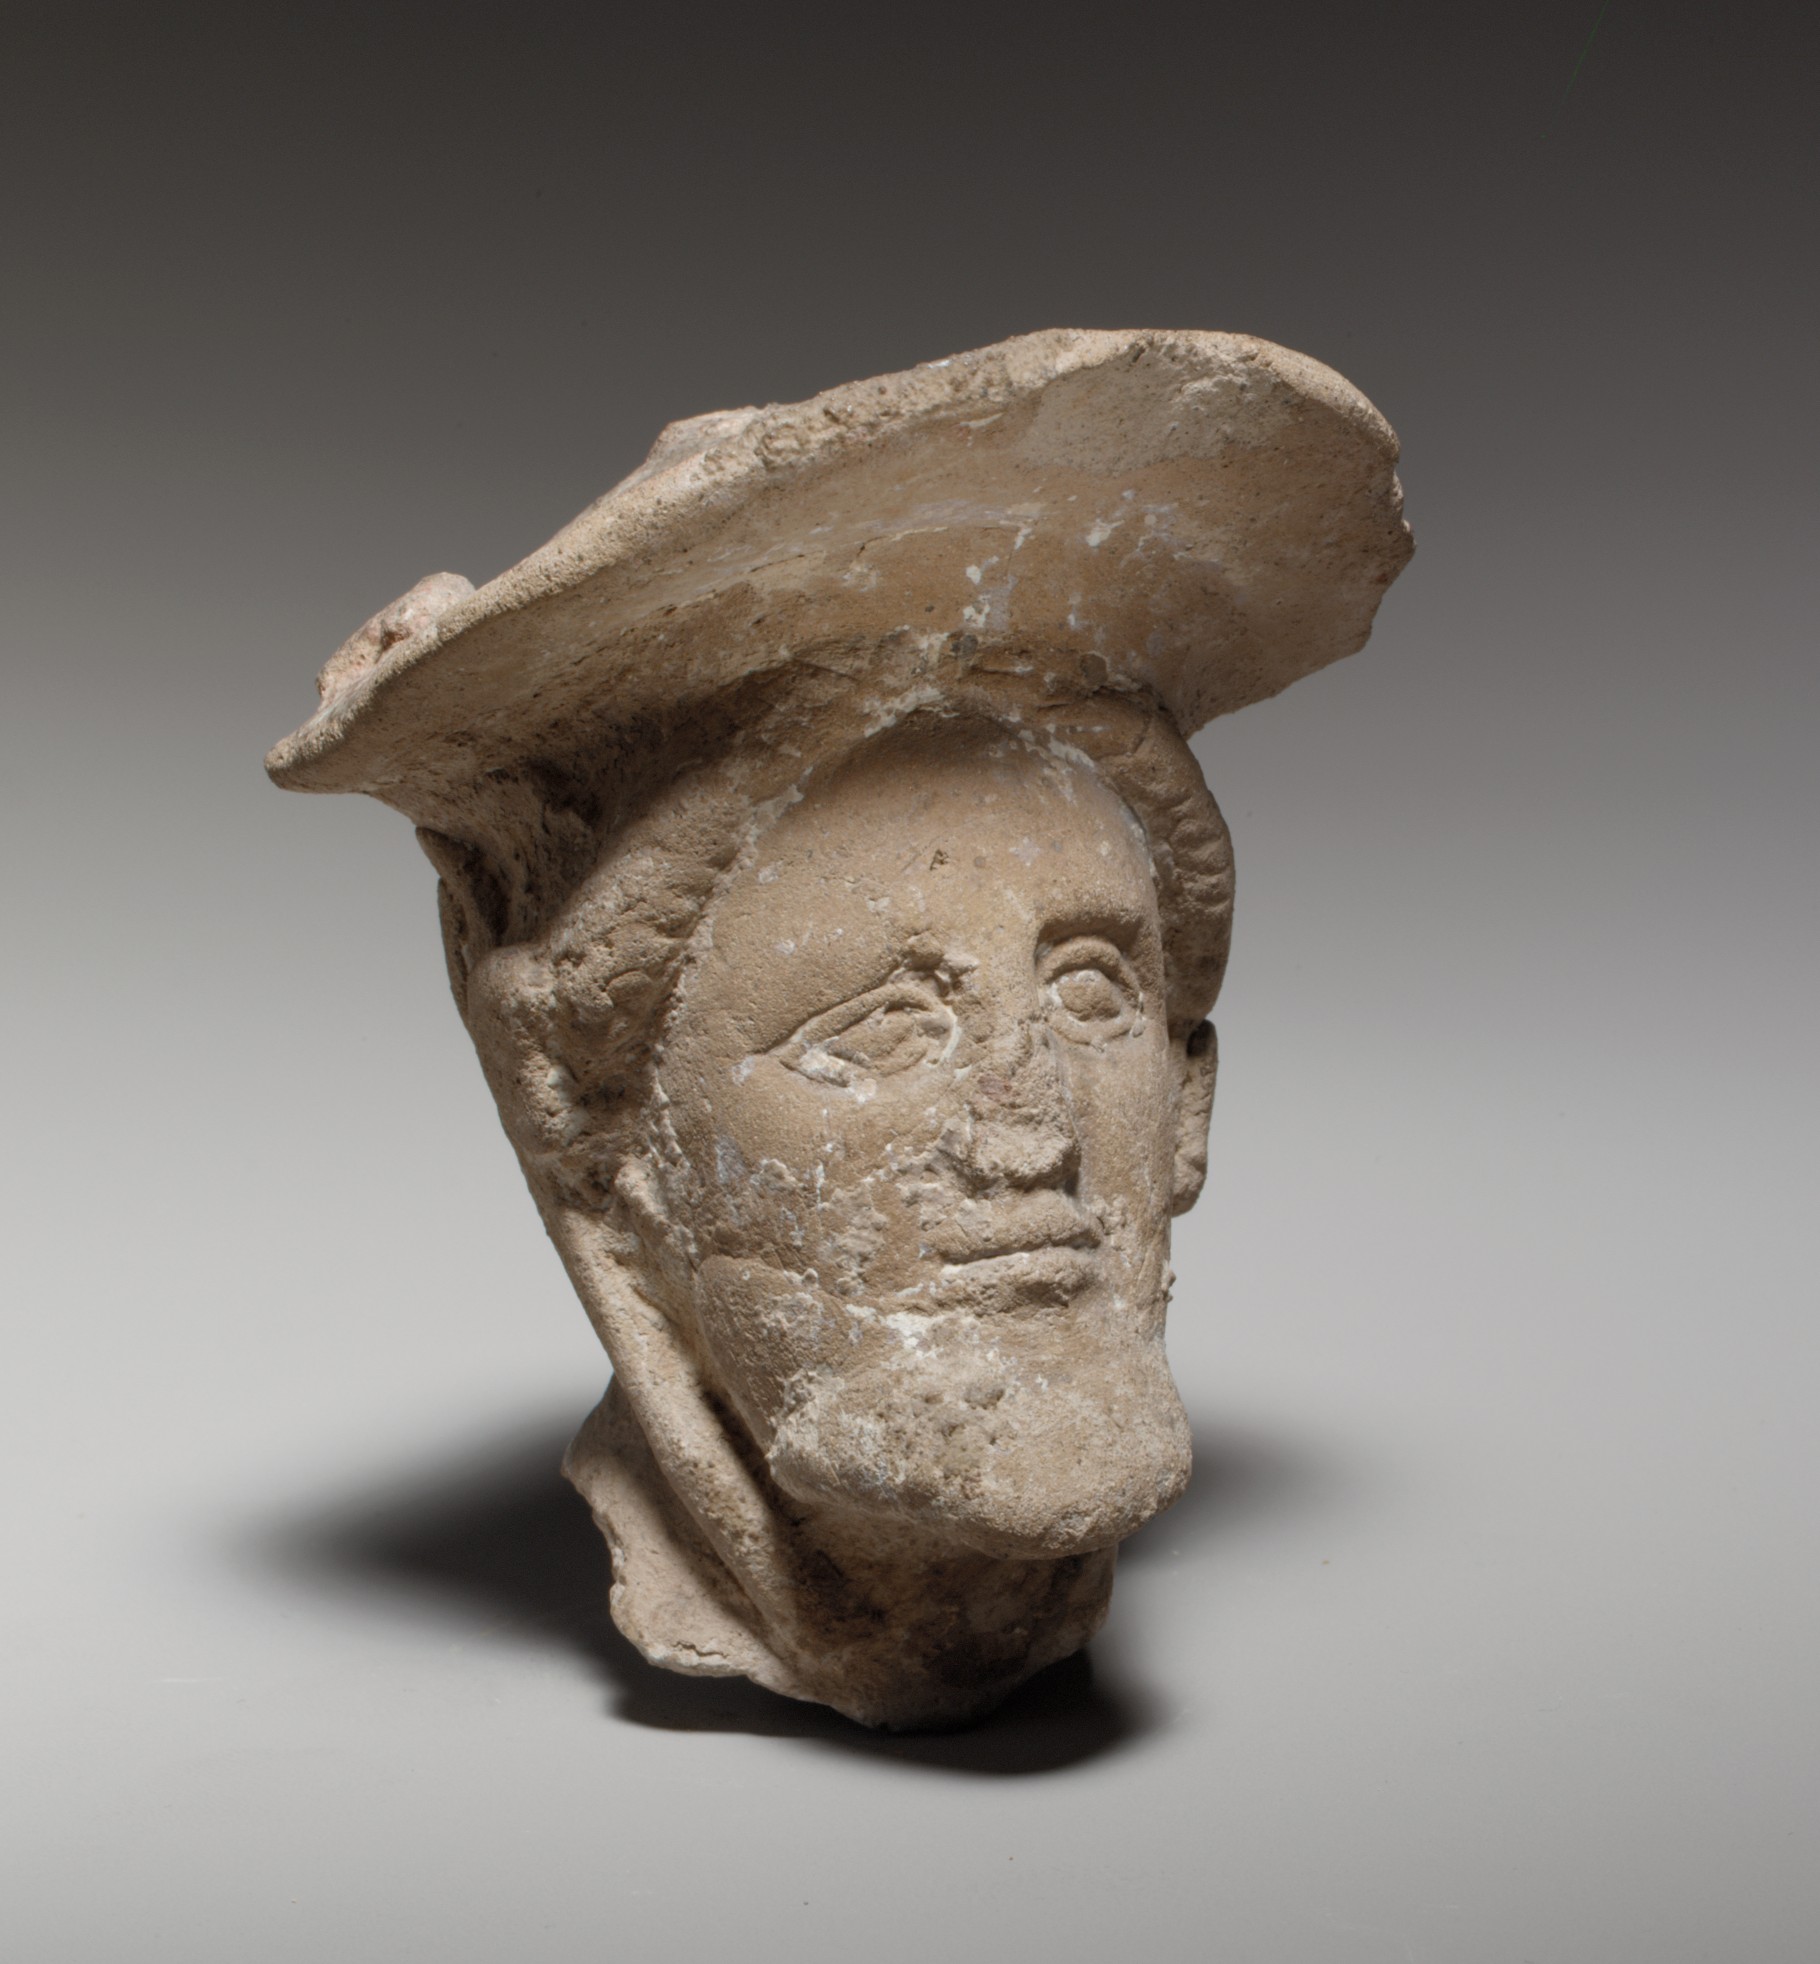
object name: head of a male votary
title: Male head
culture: cypriot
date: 400-201 BCE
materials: terracotta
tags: heads,men